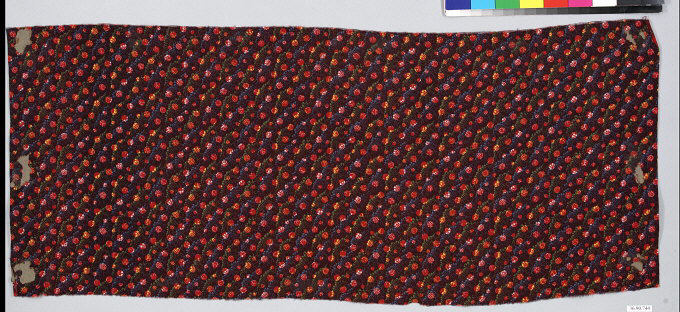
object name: piece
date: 1867-1900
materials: cotton